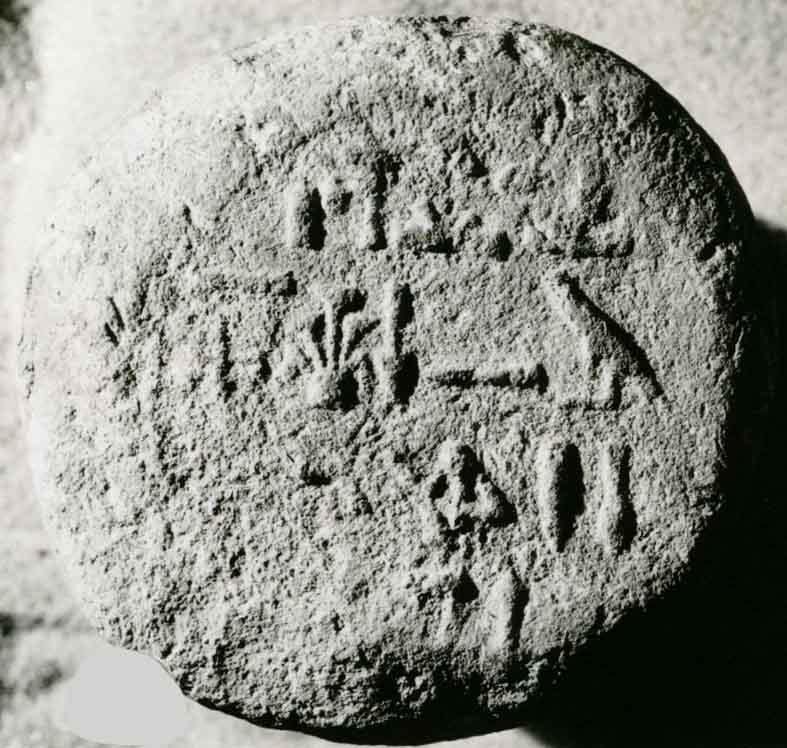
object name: cone, senemiah, circular impression, scribe, account, bread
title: Funerary Cone of the Scribe of Accounts Senemiah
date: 1550-1295 BCE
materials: pottery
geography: egypt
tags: hieroglyphs